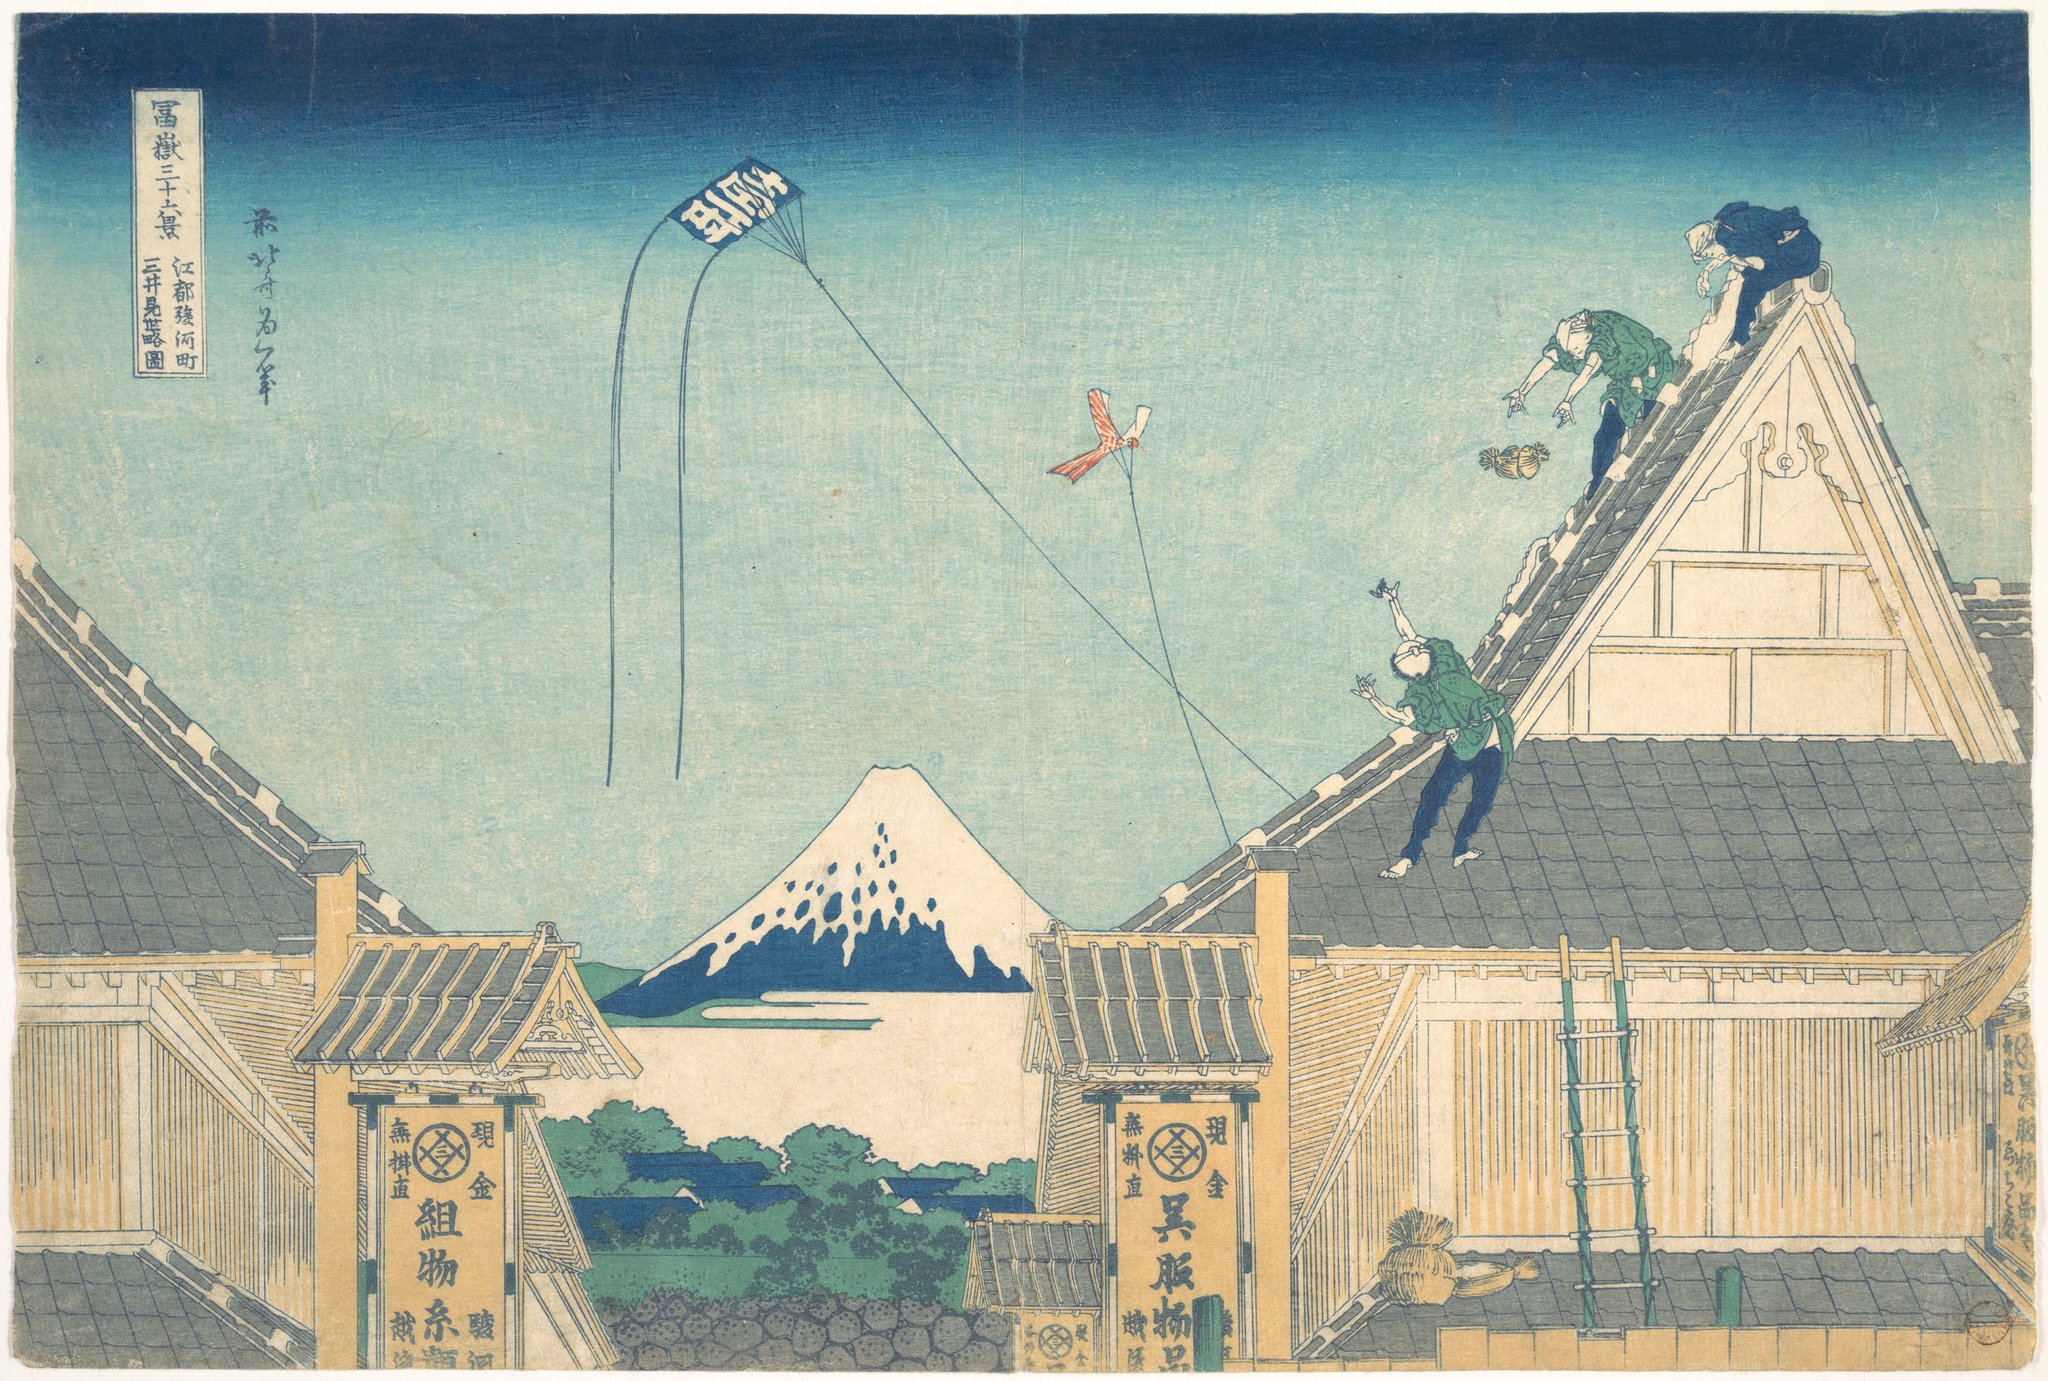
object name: woodblock print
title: Mitsui Shop at Surugachō in Edo (Edo Surugachō Mitsui mise ryaku zu), from the series Thirty-six Views of Mount Fuji (Fugaku sanjūrokkei)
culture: japanese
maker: katsushika hokusai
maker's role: artist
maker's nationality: japanese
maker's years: 1760-1849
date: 1830-1832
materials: ink, paper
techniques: woodblock print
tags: roofs,men,volcanoes,ladders